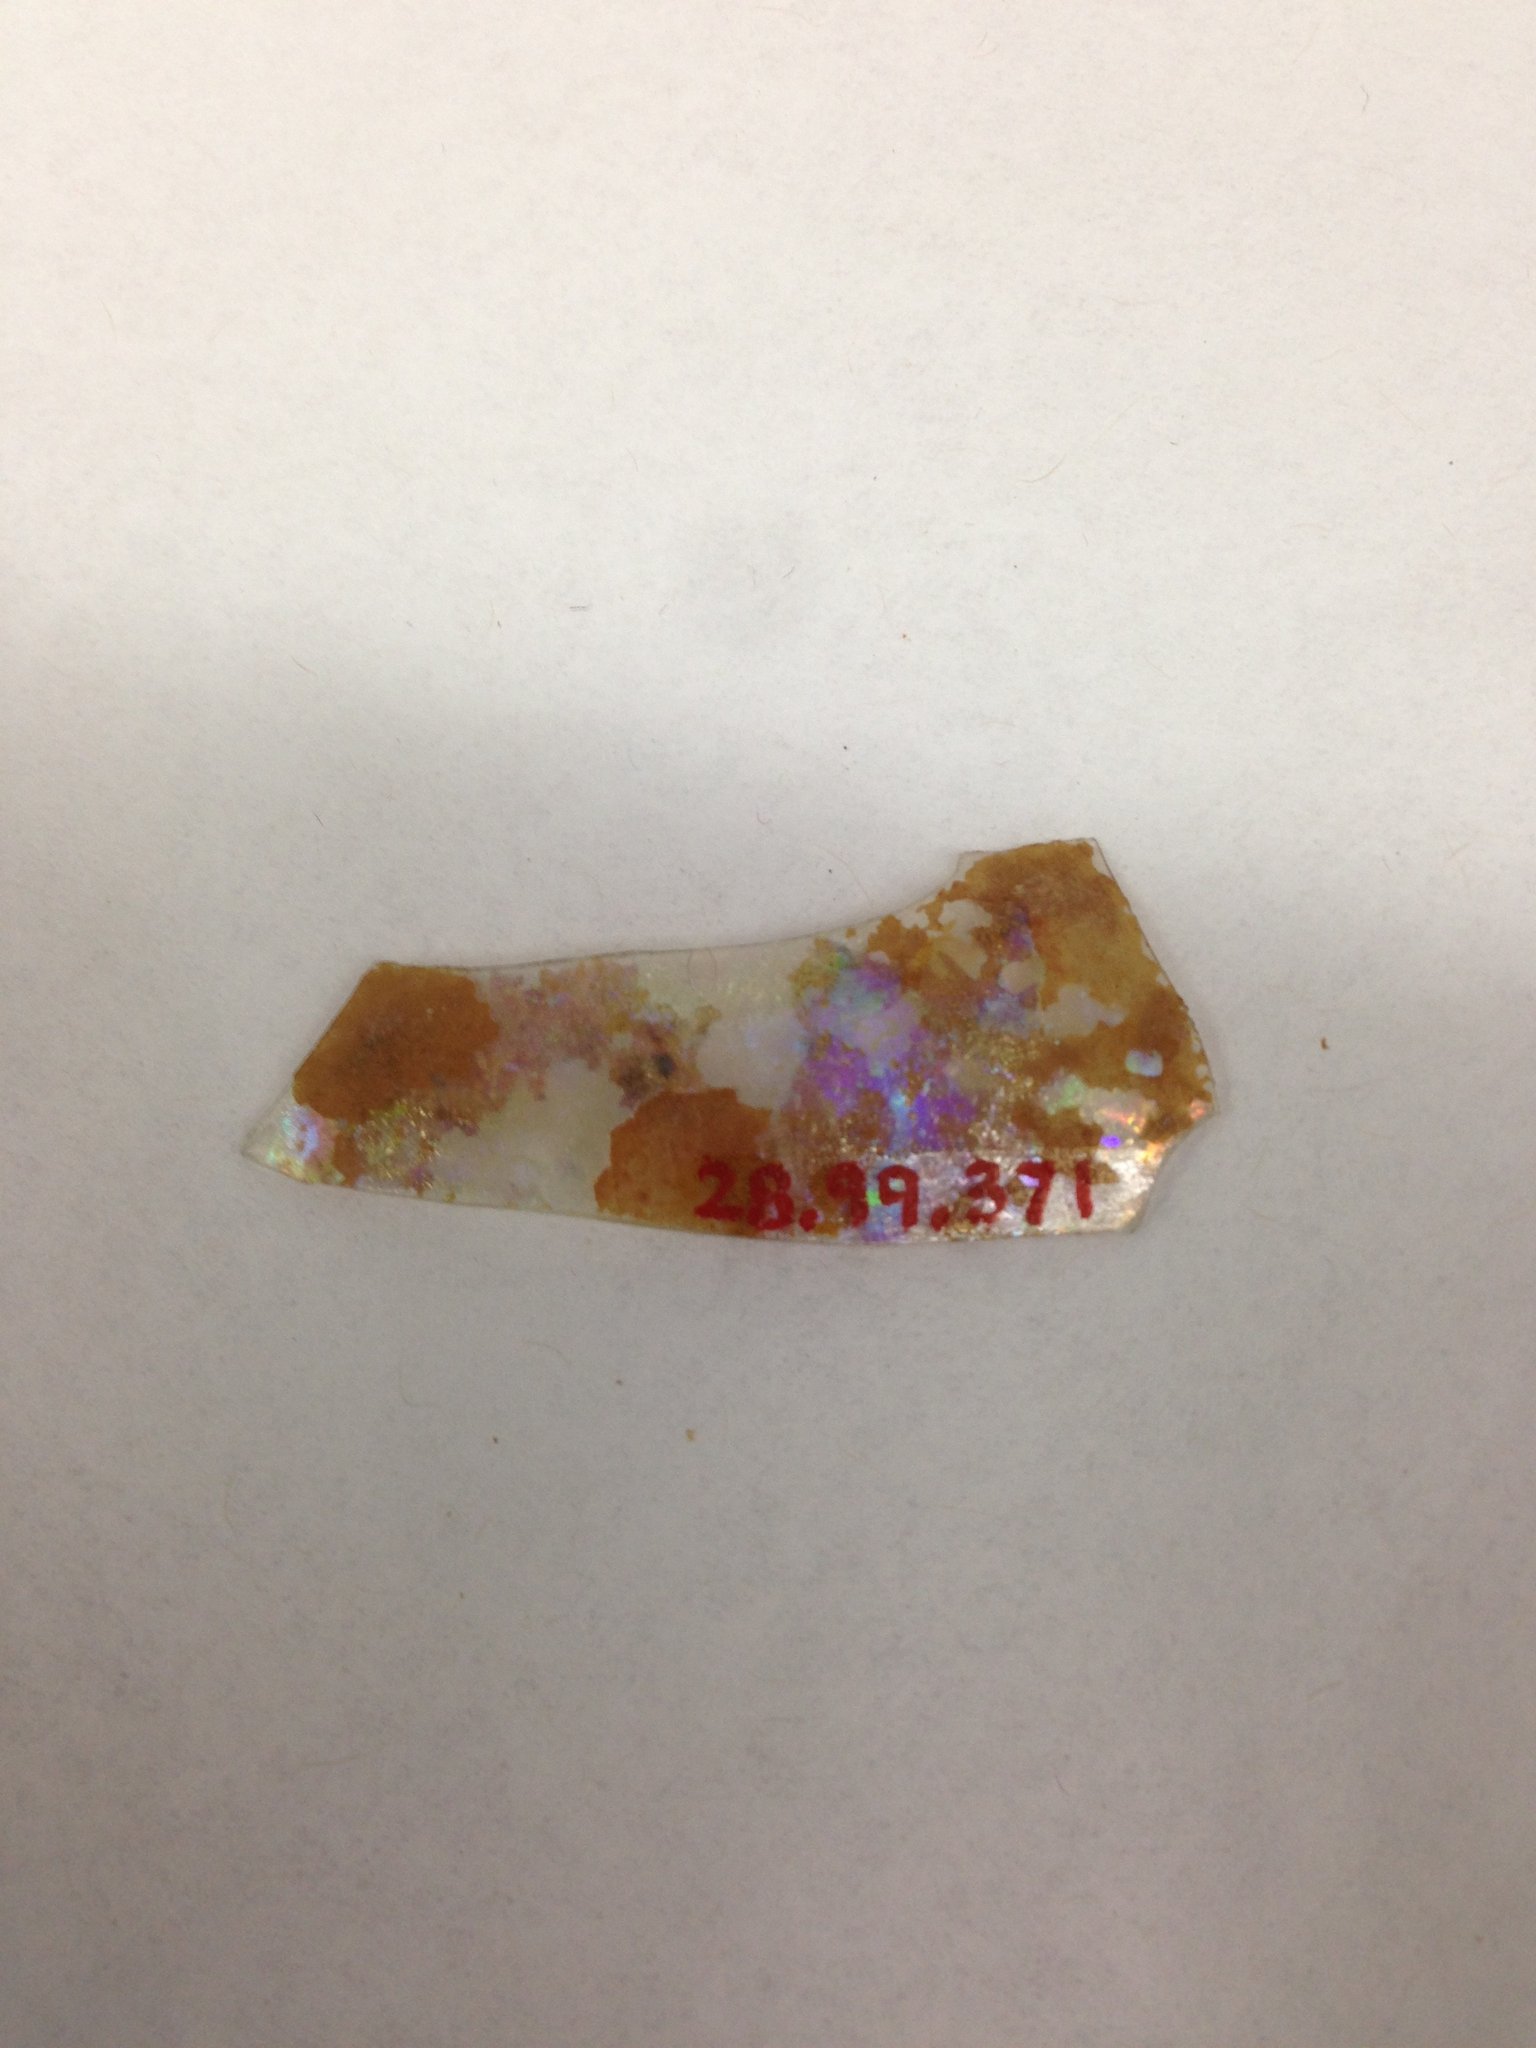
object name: fragment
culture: european or middle eastern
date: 1150-1250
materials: ceramic, glass